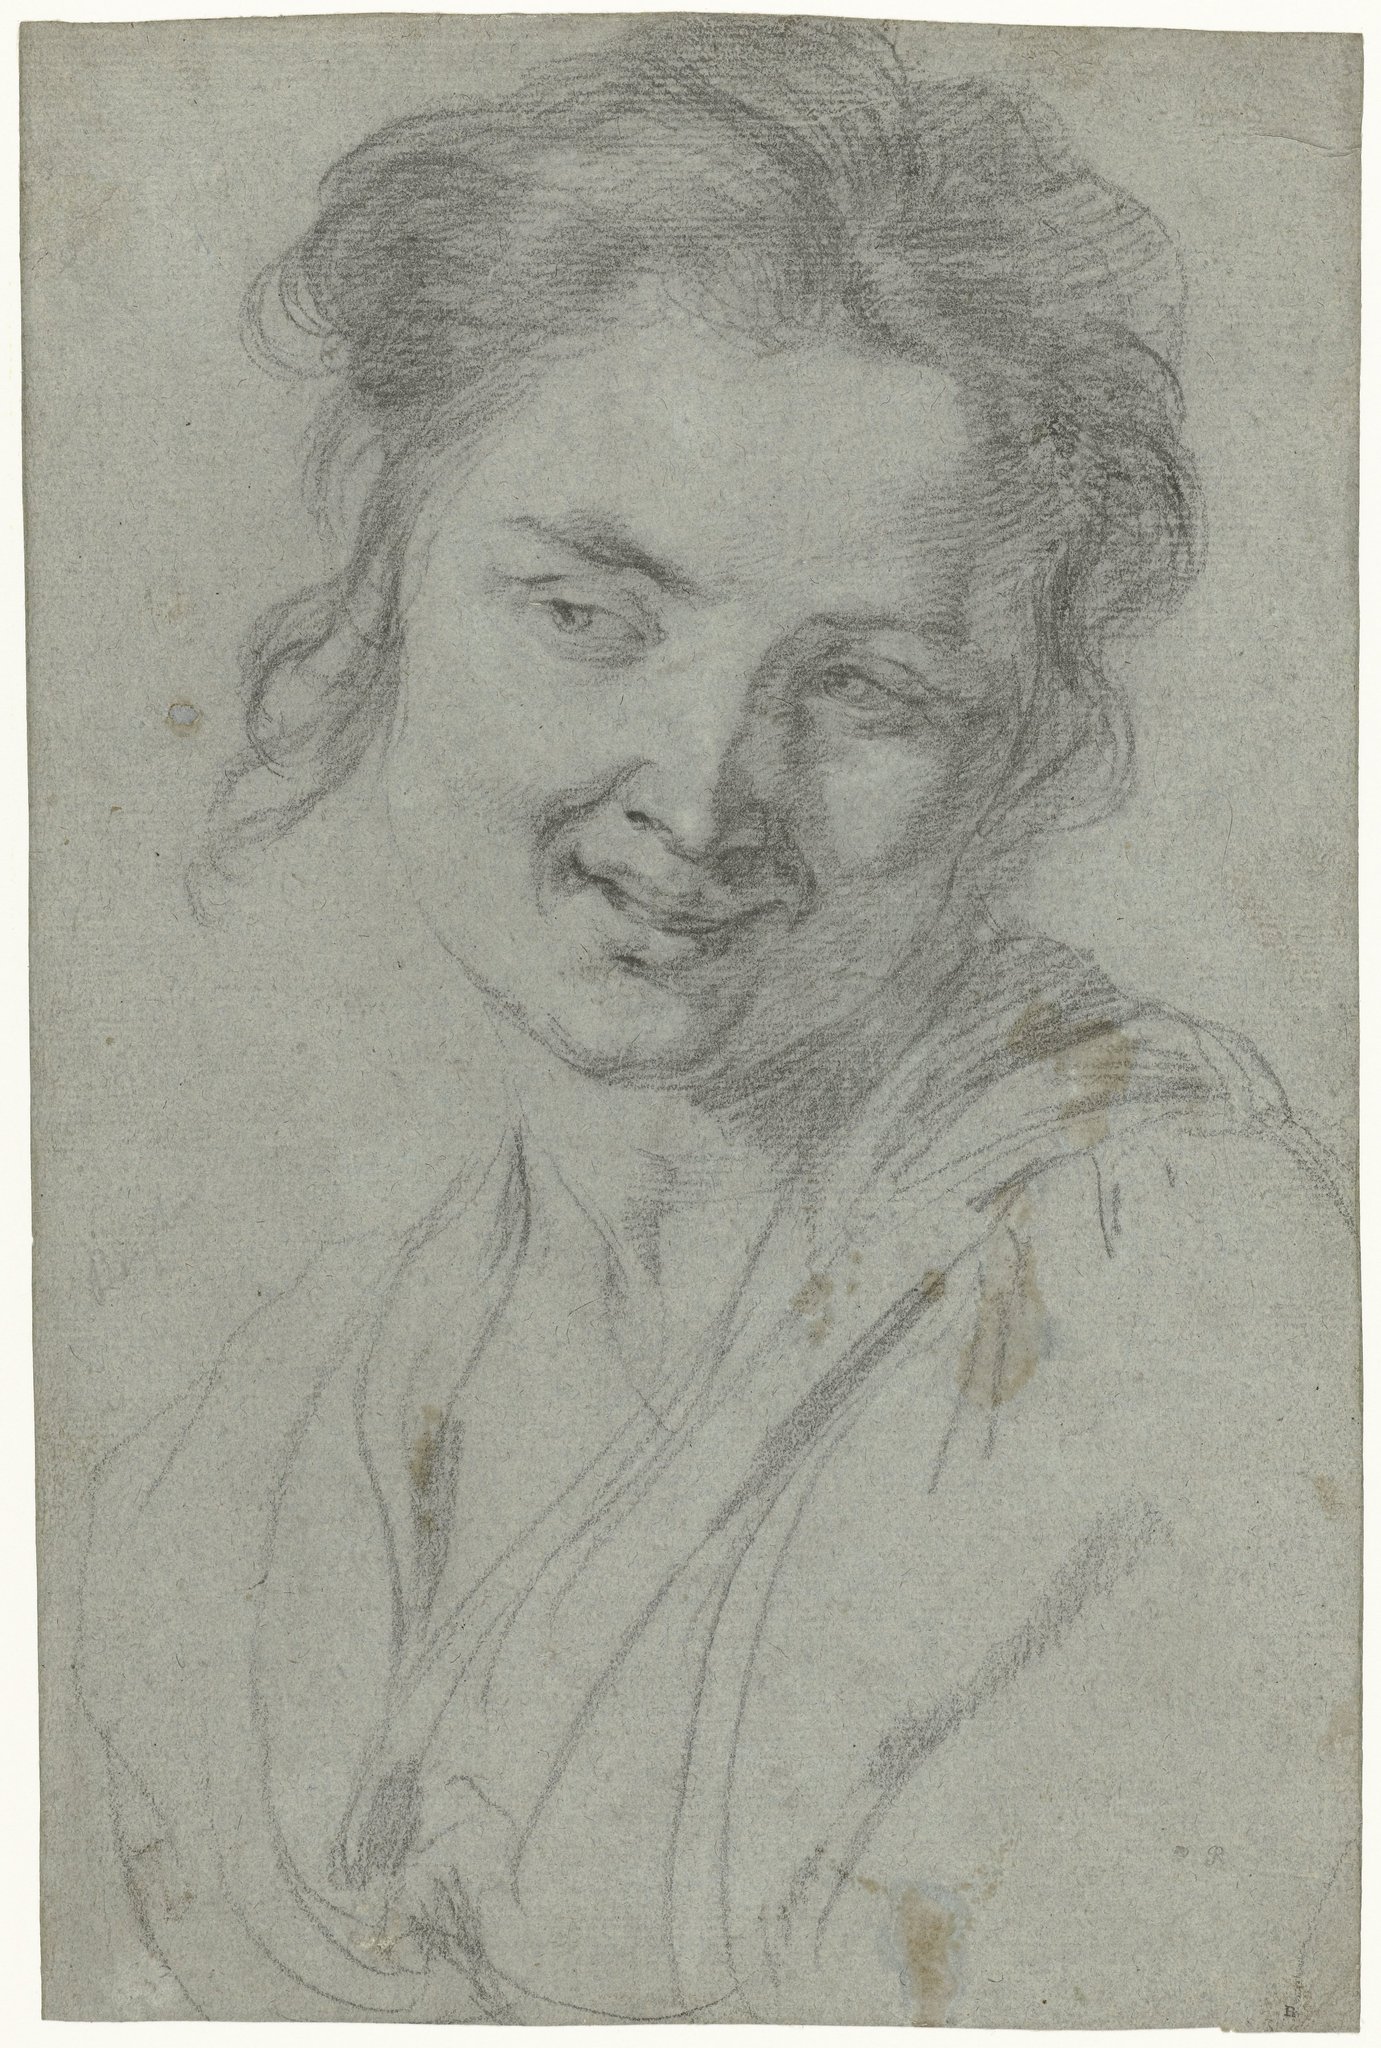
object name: drawing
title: Studie van een lachende vrouw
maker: johann liss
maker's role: draughtsman, painter, print maker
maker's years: 1597-1631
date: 1616-1619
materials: chalk, paper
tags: laughing